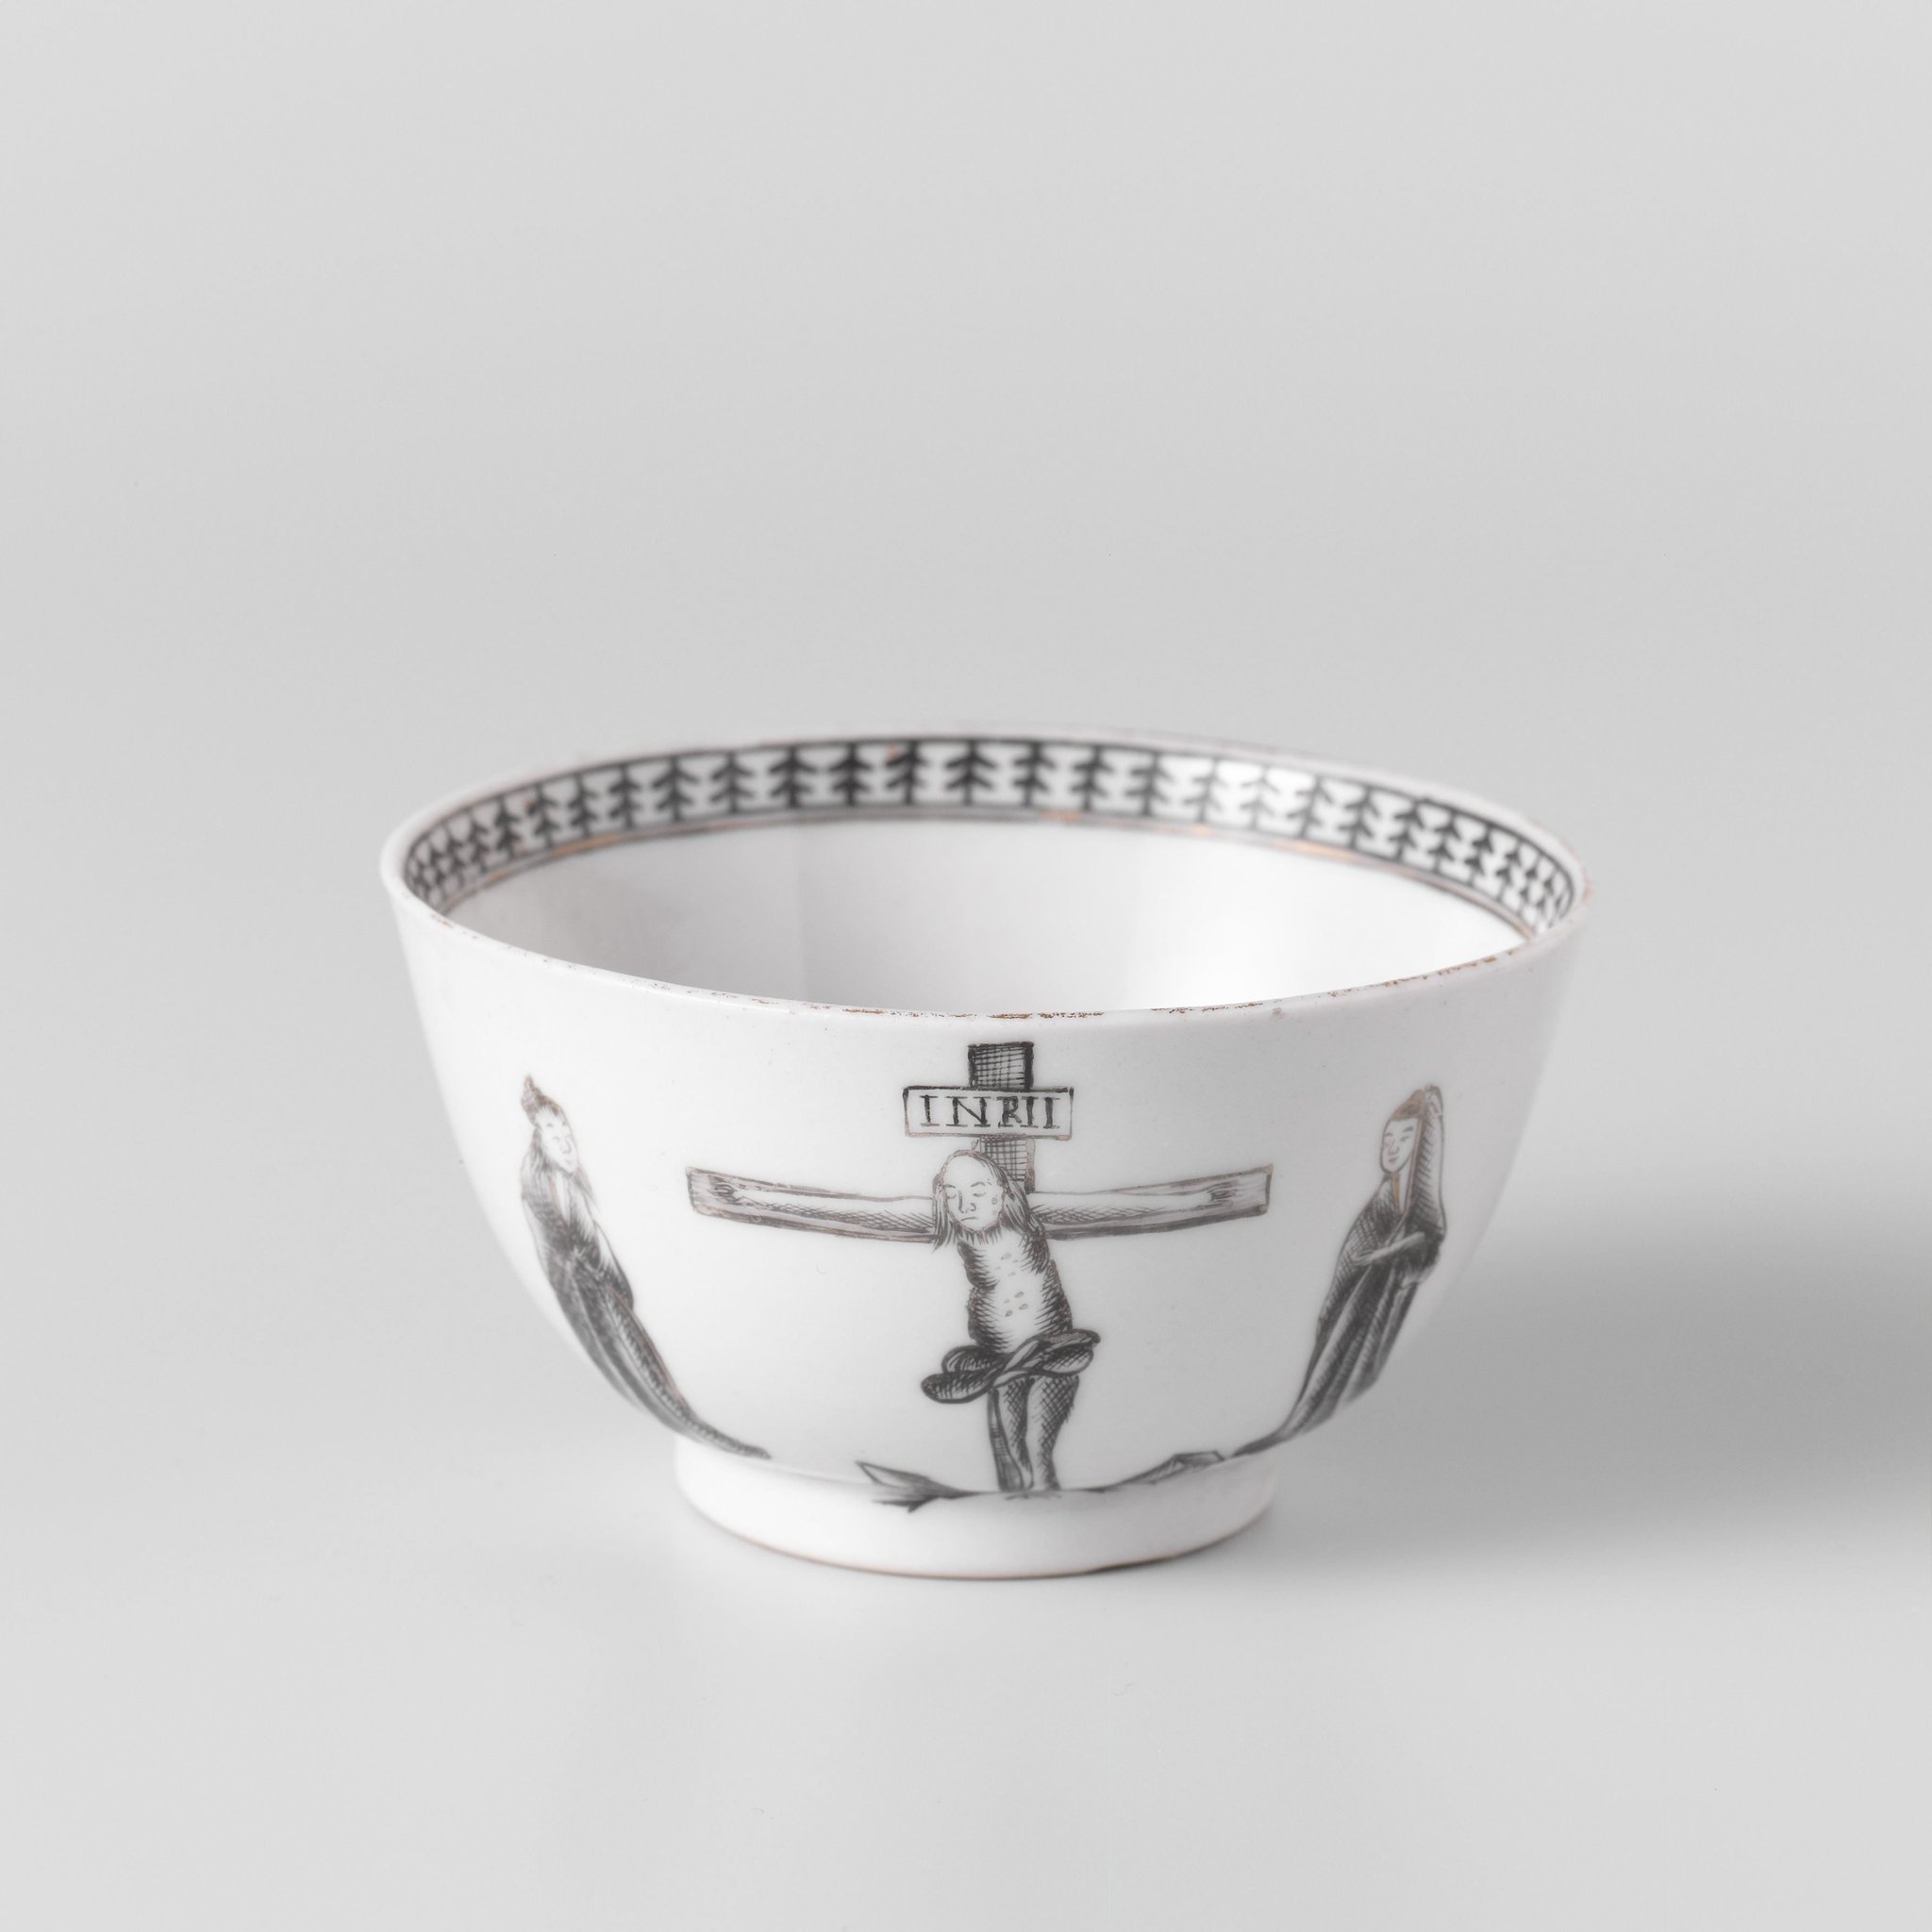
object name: cup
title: Bell-shaped cup with a crucifixion scene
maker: Anonymous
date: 1780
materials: glaze, gold, paint, porcelain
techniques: firing, gilding, turning, vitrification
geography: china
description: Kop op voetring, gedecoreerd in encre de Chine en goud met een voorstelling van de Kruisiging. Behorend tot theeservies.